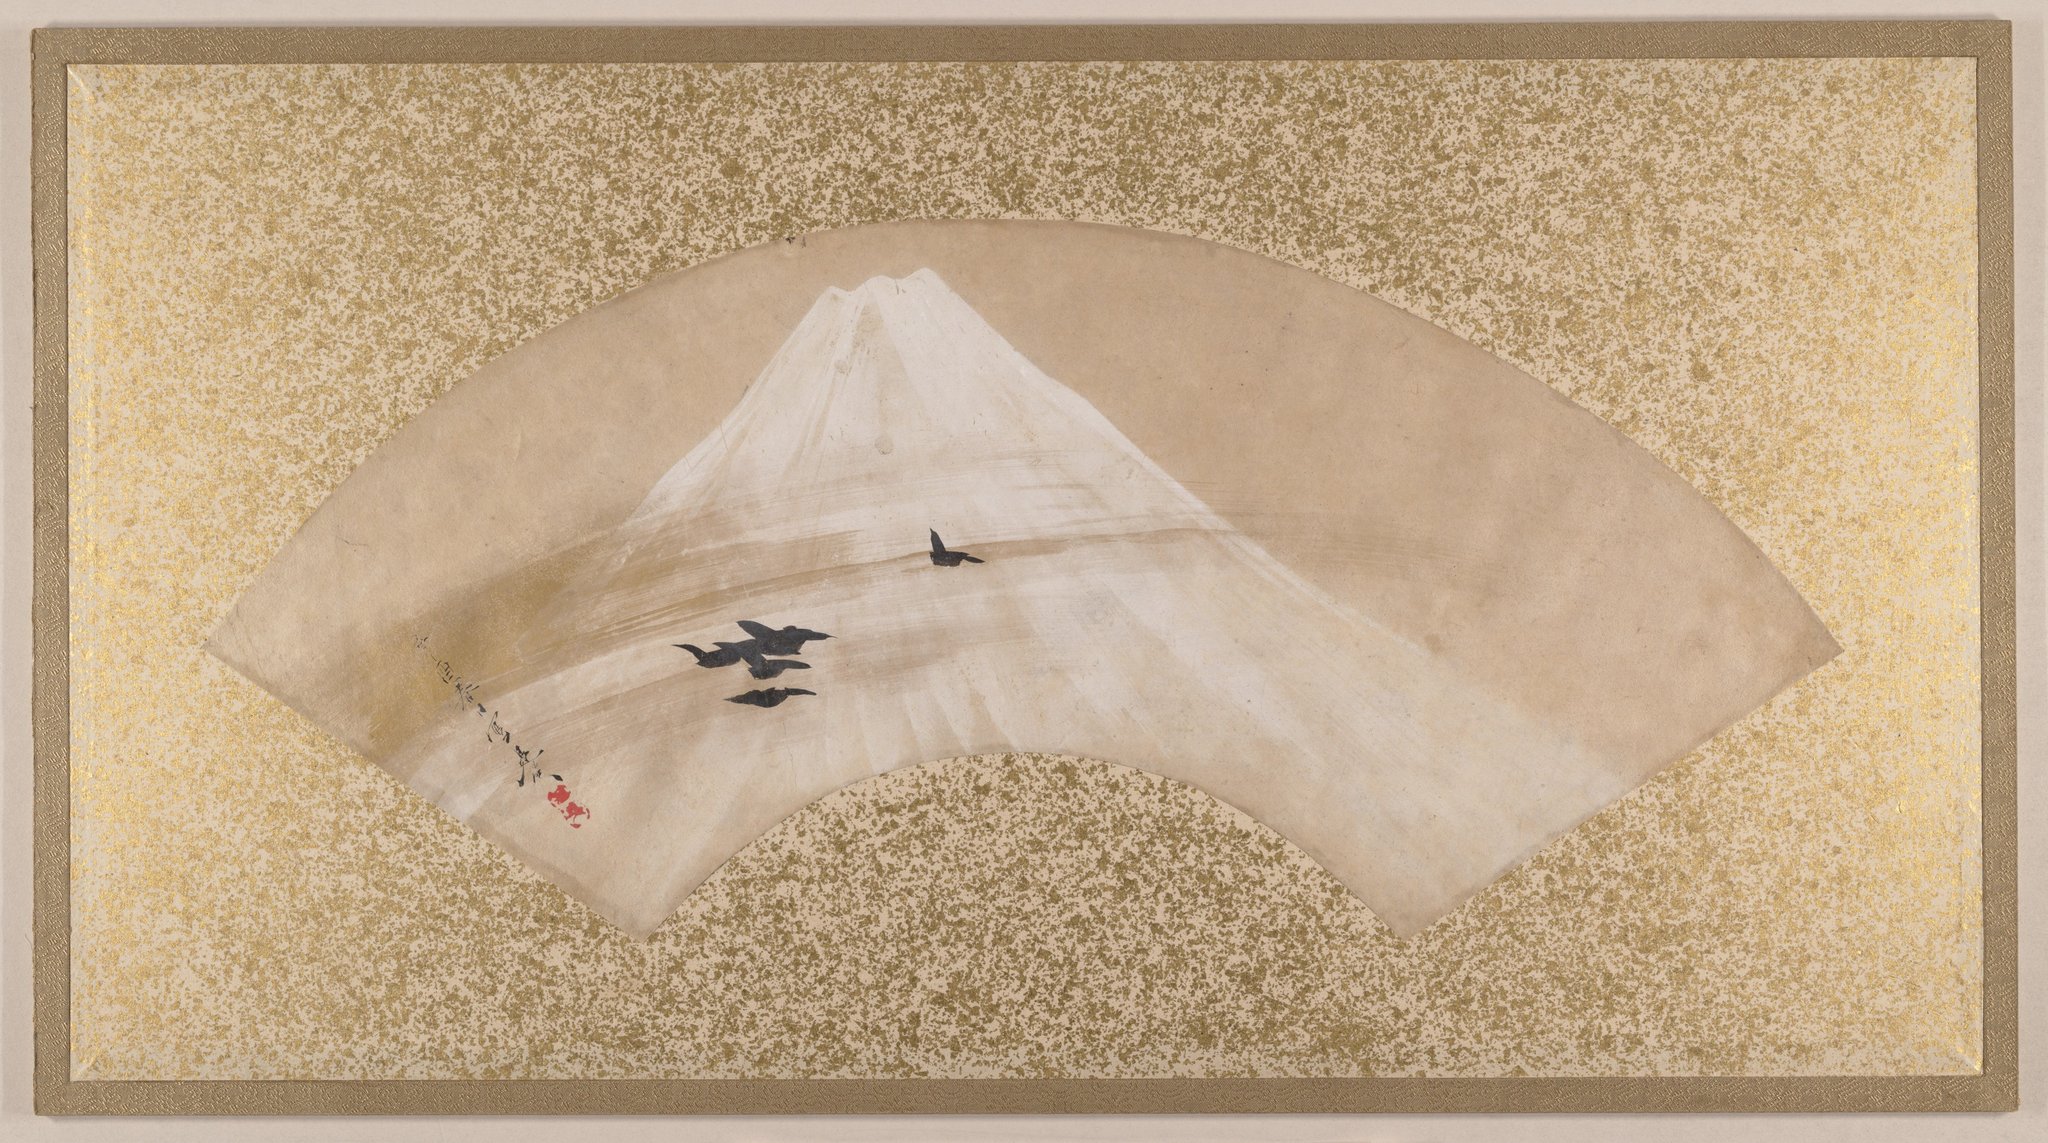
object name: album leaf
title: Mountains with Birds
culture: japanese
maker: shibata zeshin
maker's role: artist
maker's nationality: japanese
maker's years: 1807-1891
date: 1867-1900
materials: paper, paint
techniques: painting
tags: birds,mountains